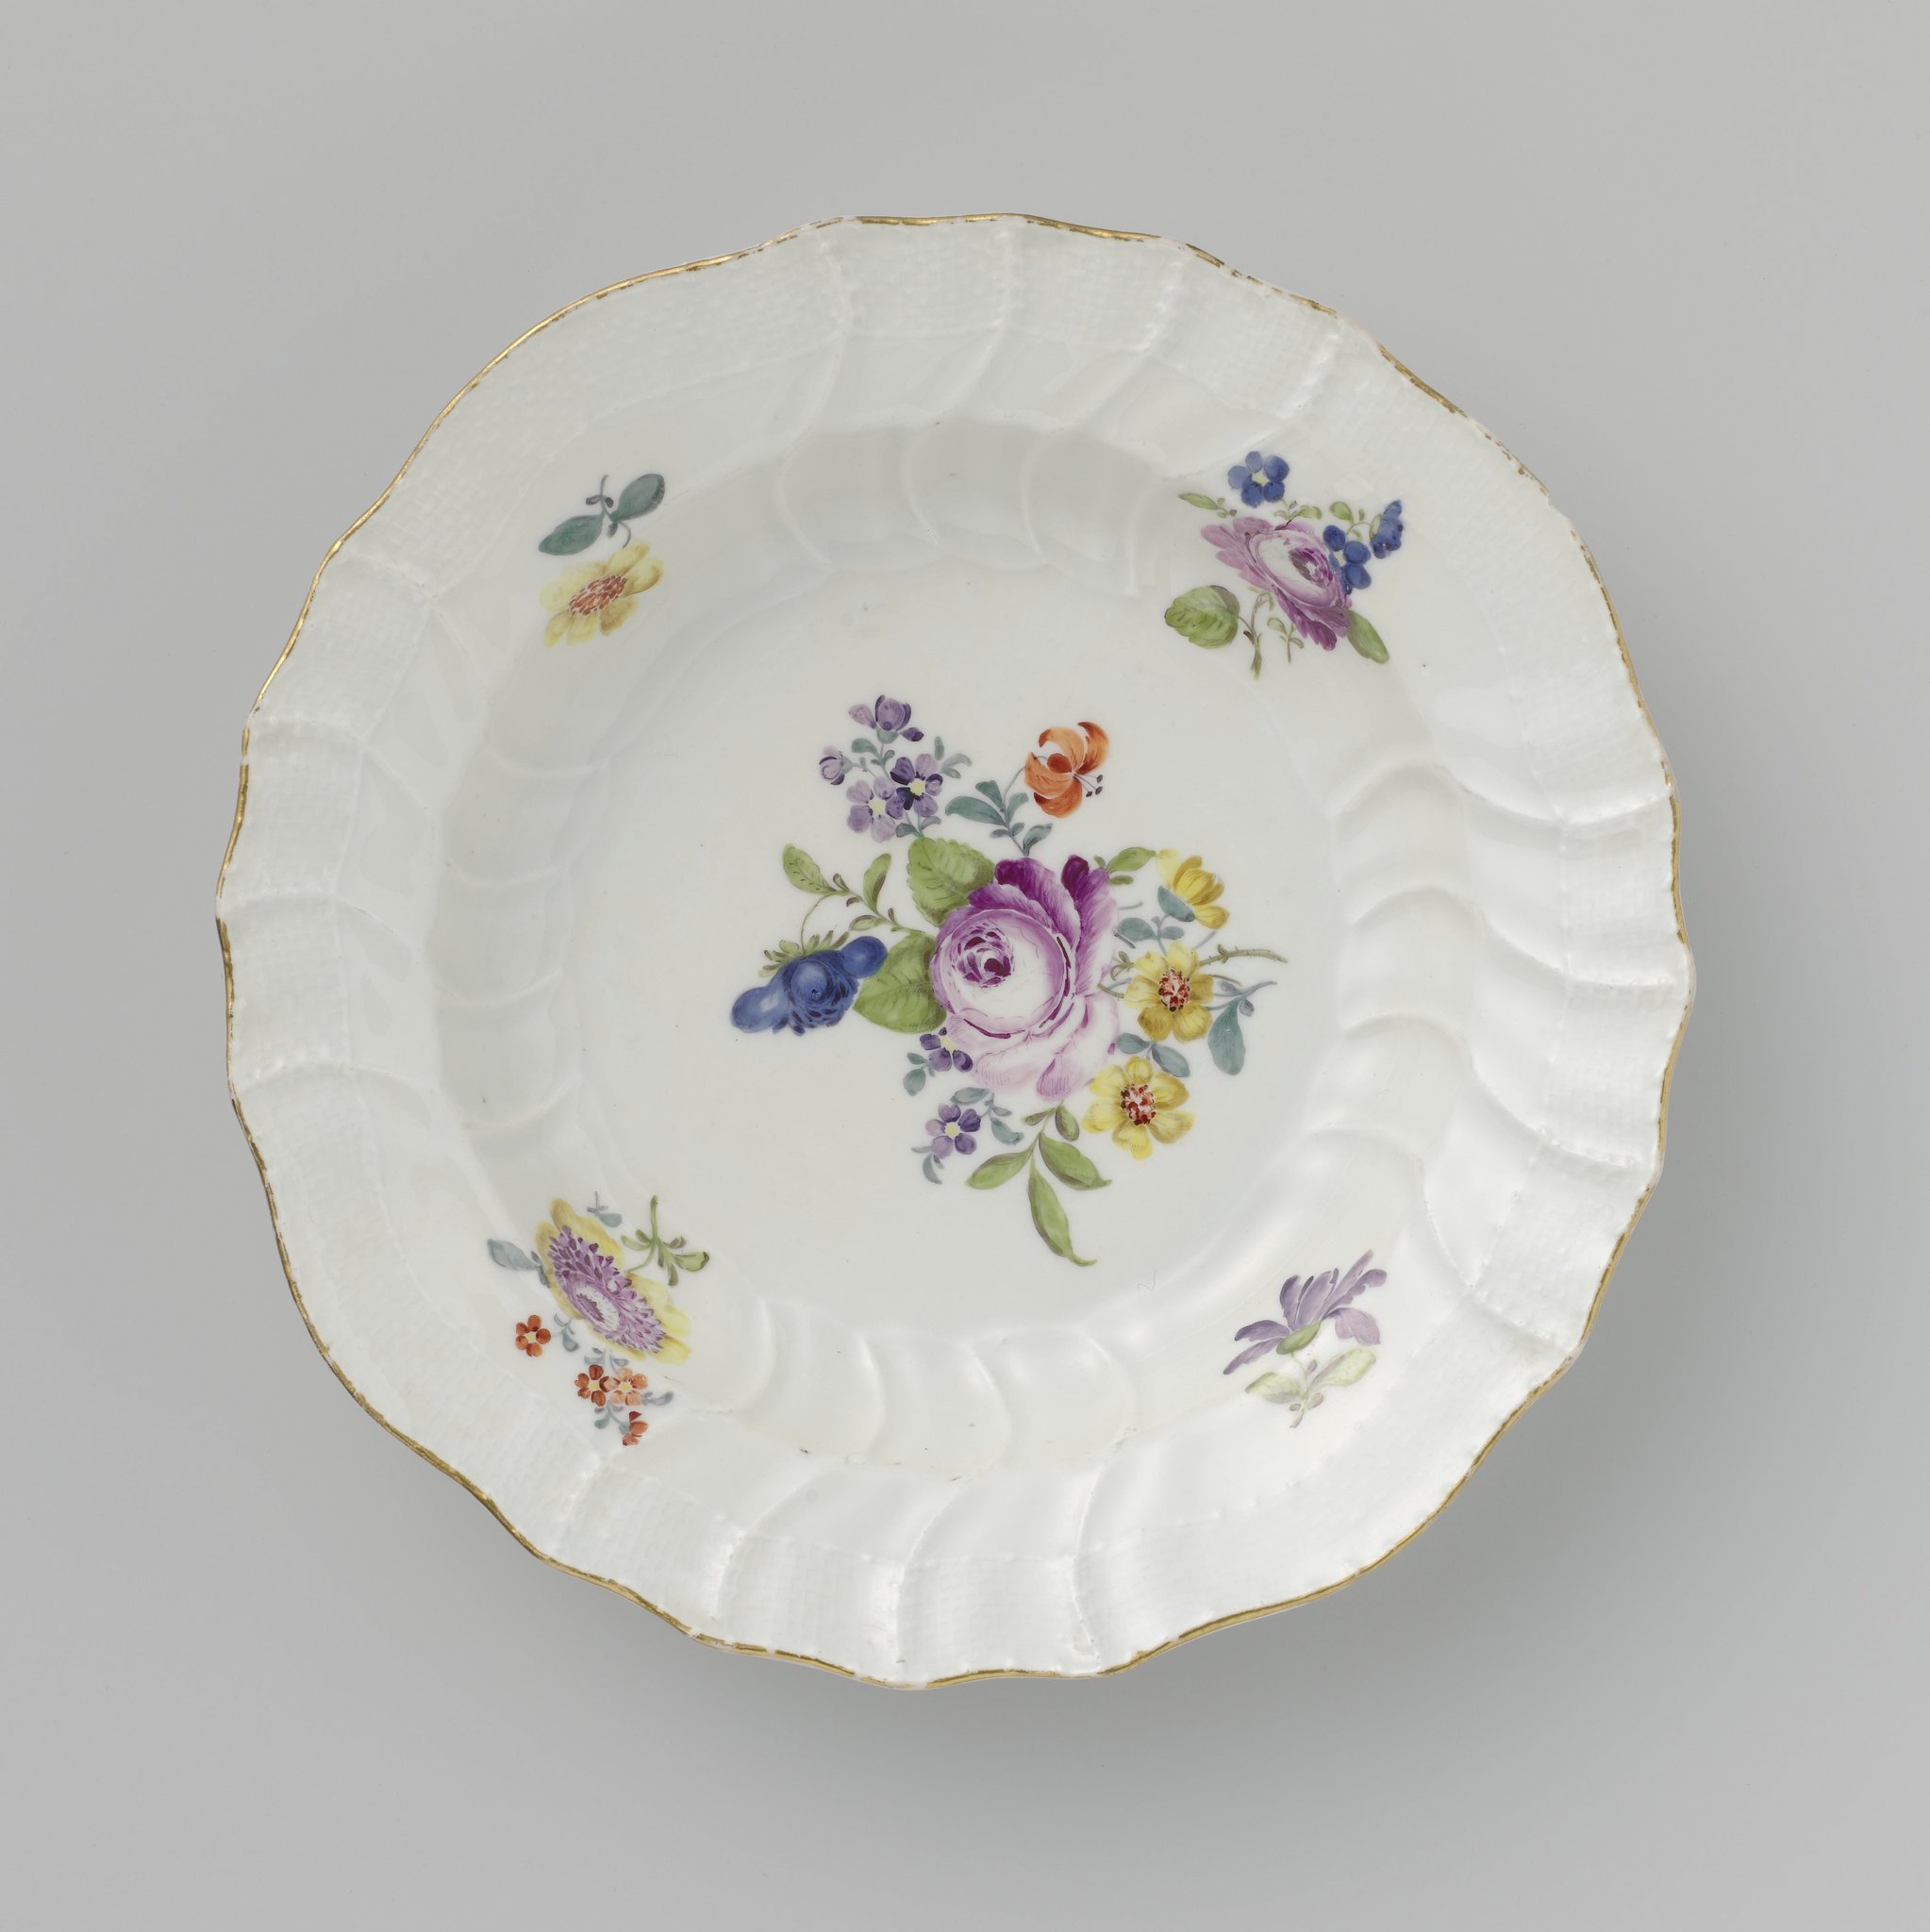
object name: eating drinking utensil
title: Bord, veelkleurig beschilderd met Deutsche Blumen, insekten en vruchten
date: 1750-1760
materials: porcelain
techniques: painted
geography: meissen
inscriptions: factory mark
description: Rond soepbord van beschilderd porselein. Het bord is beschilderd met Deutsche Blumen, insekten en vruchten. De rand is in reliëf versierd met het Neuozier-patroon. Het bord is gemerkt en hoort bij een servies (BK-17474-1 t/m BK-17474-253).